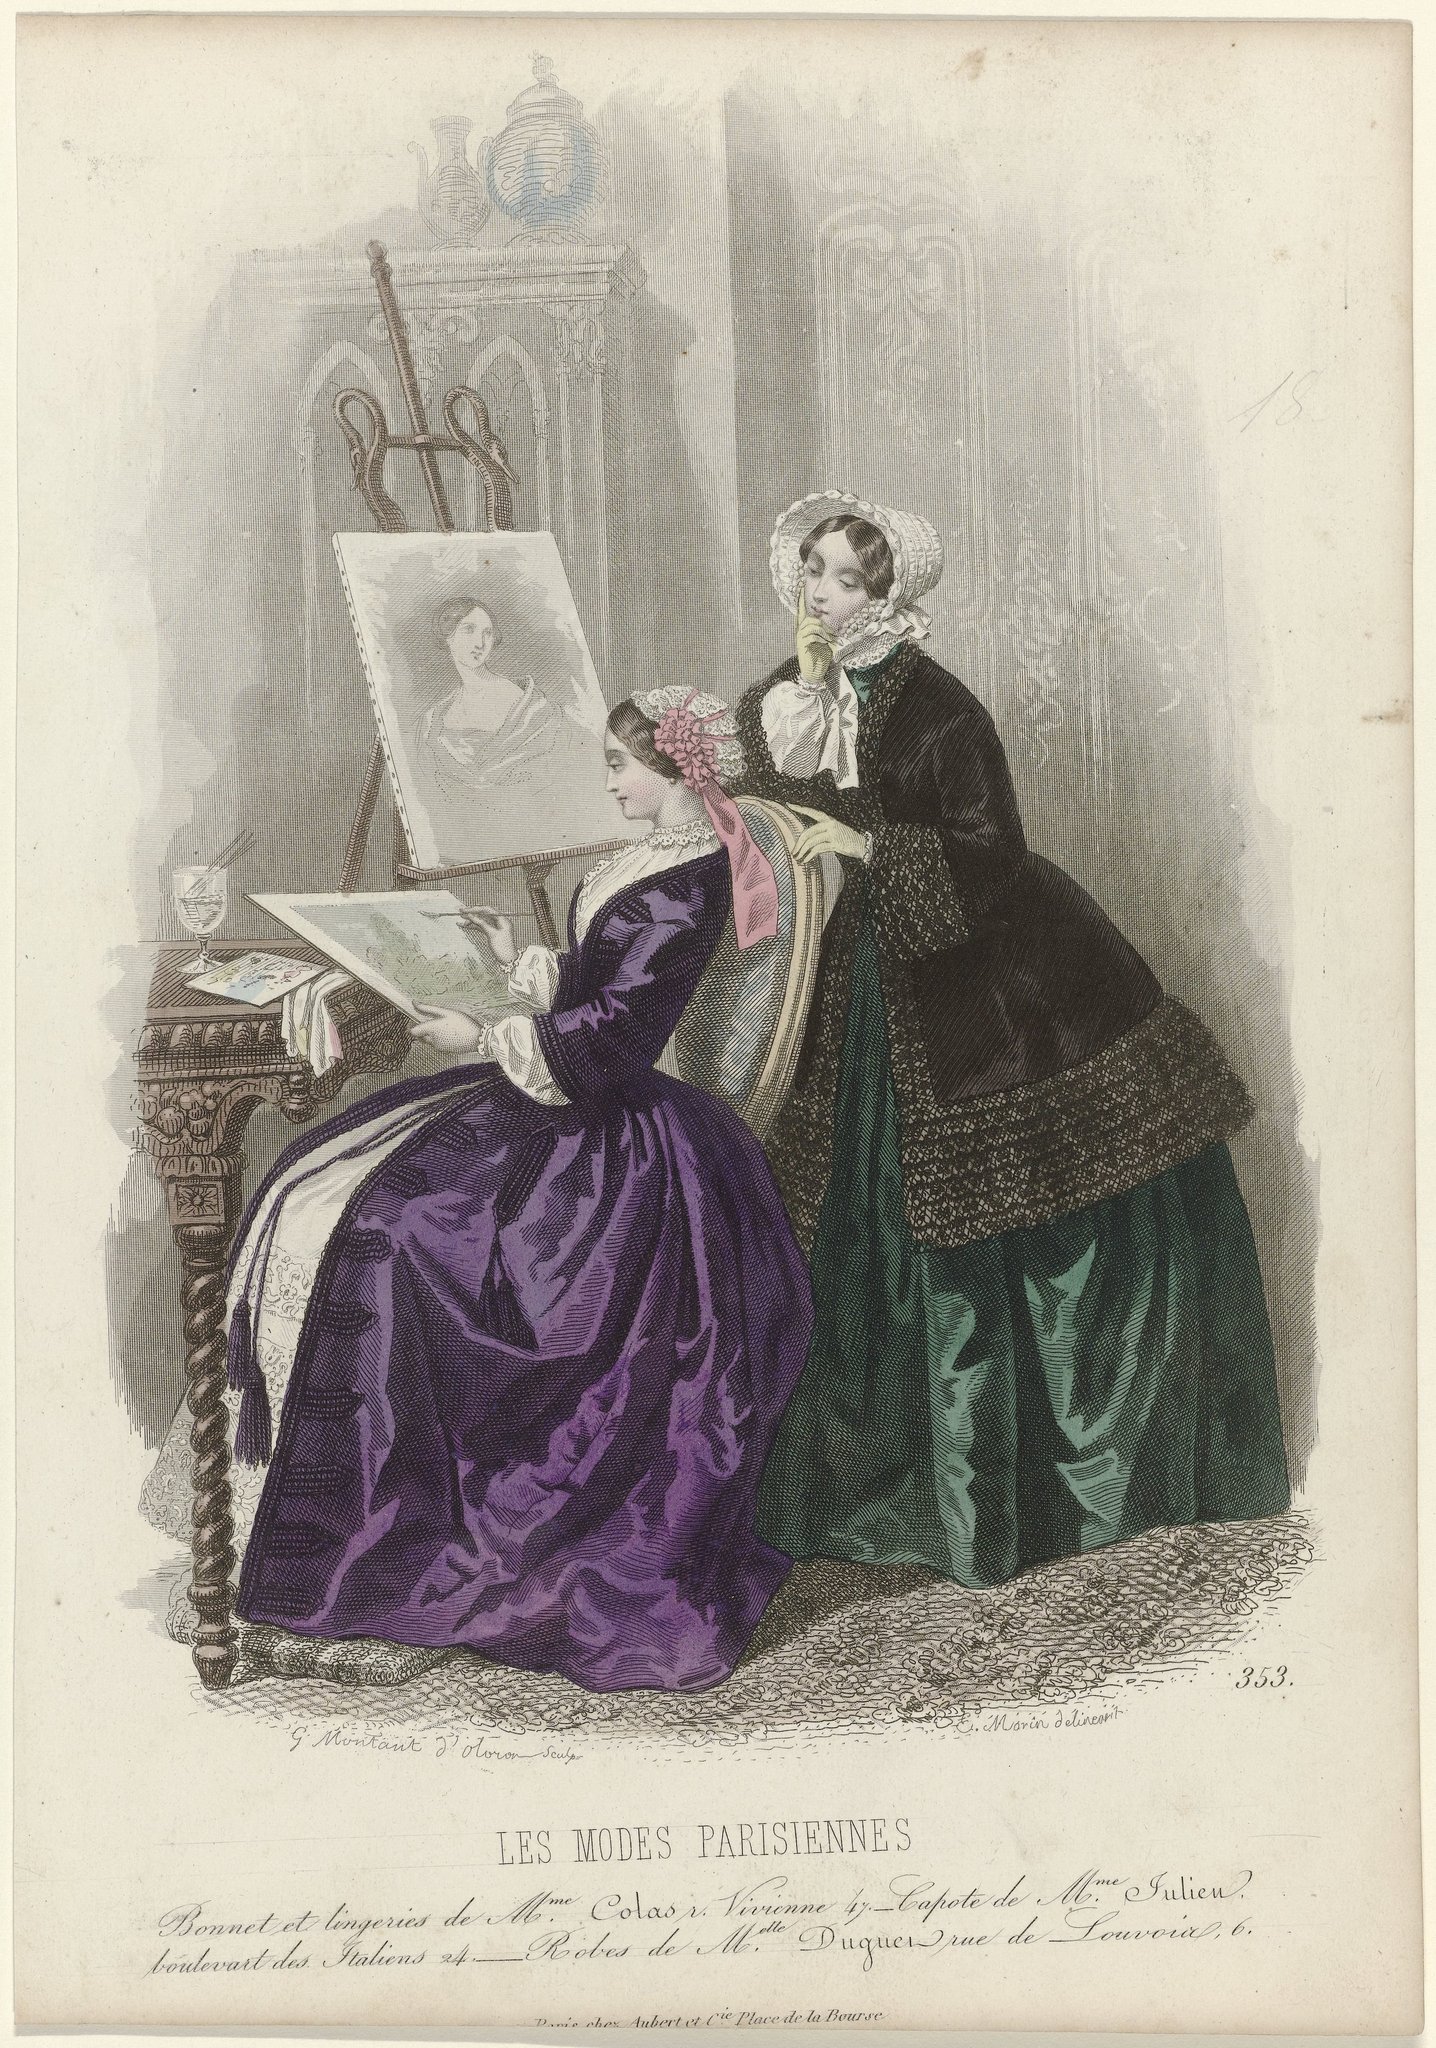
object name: fashion print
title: Les Modes Parisiennes, 1849, No. 353 : Bonnet et lingeries (...)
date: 1849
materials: paper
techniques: engraving, hand coloring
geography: paris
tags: head-gear (capote) (+ women's clothes), painter at work, in his studio (+ the work of art and its production), coat (+ women's clothes), head-gear: cap (+ women's clothes), fashion plates, skirt (+ women's clothes), dress, gown (+ women's clothes), easel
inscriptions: caption: ‘Bonnet et lingeries de M.me Colas r. Vivienne 47._ Capote de M.me Julien. boulevart des Italiens 24._Robes de M.elle Duguet rue de Louvoir, 6.’, title: ‘Les Modes Parisiennes.’, address: ‘Paris chez Aubert et C.ie Place de la Bourse.’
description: Twee vrouwen in een interieur bij een schilderezel. De zittende vrouw is aan het schilderen, terwijl de ander over de stoel meekijkt. Volgens het onderschrift: muts en 'lingeries' van Colas. 'Capote' van Julien. Japonnen van Duguet. Prent uit het modetijdschrift Les Modes Parisiennes (1843-1885).